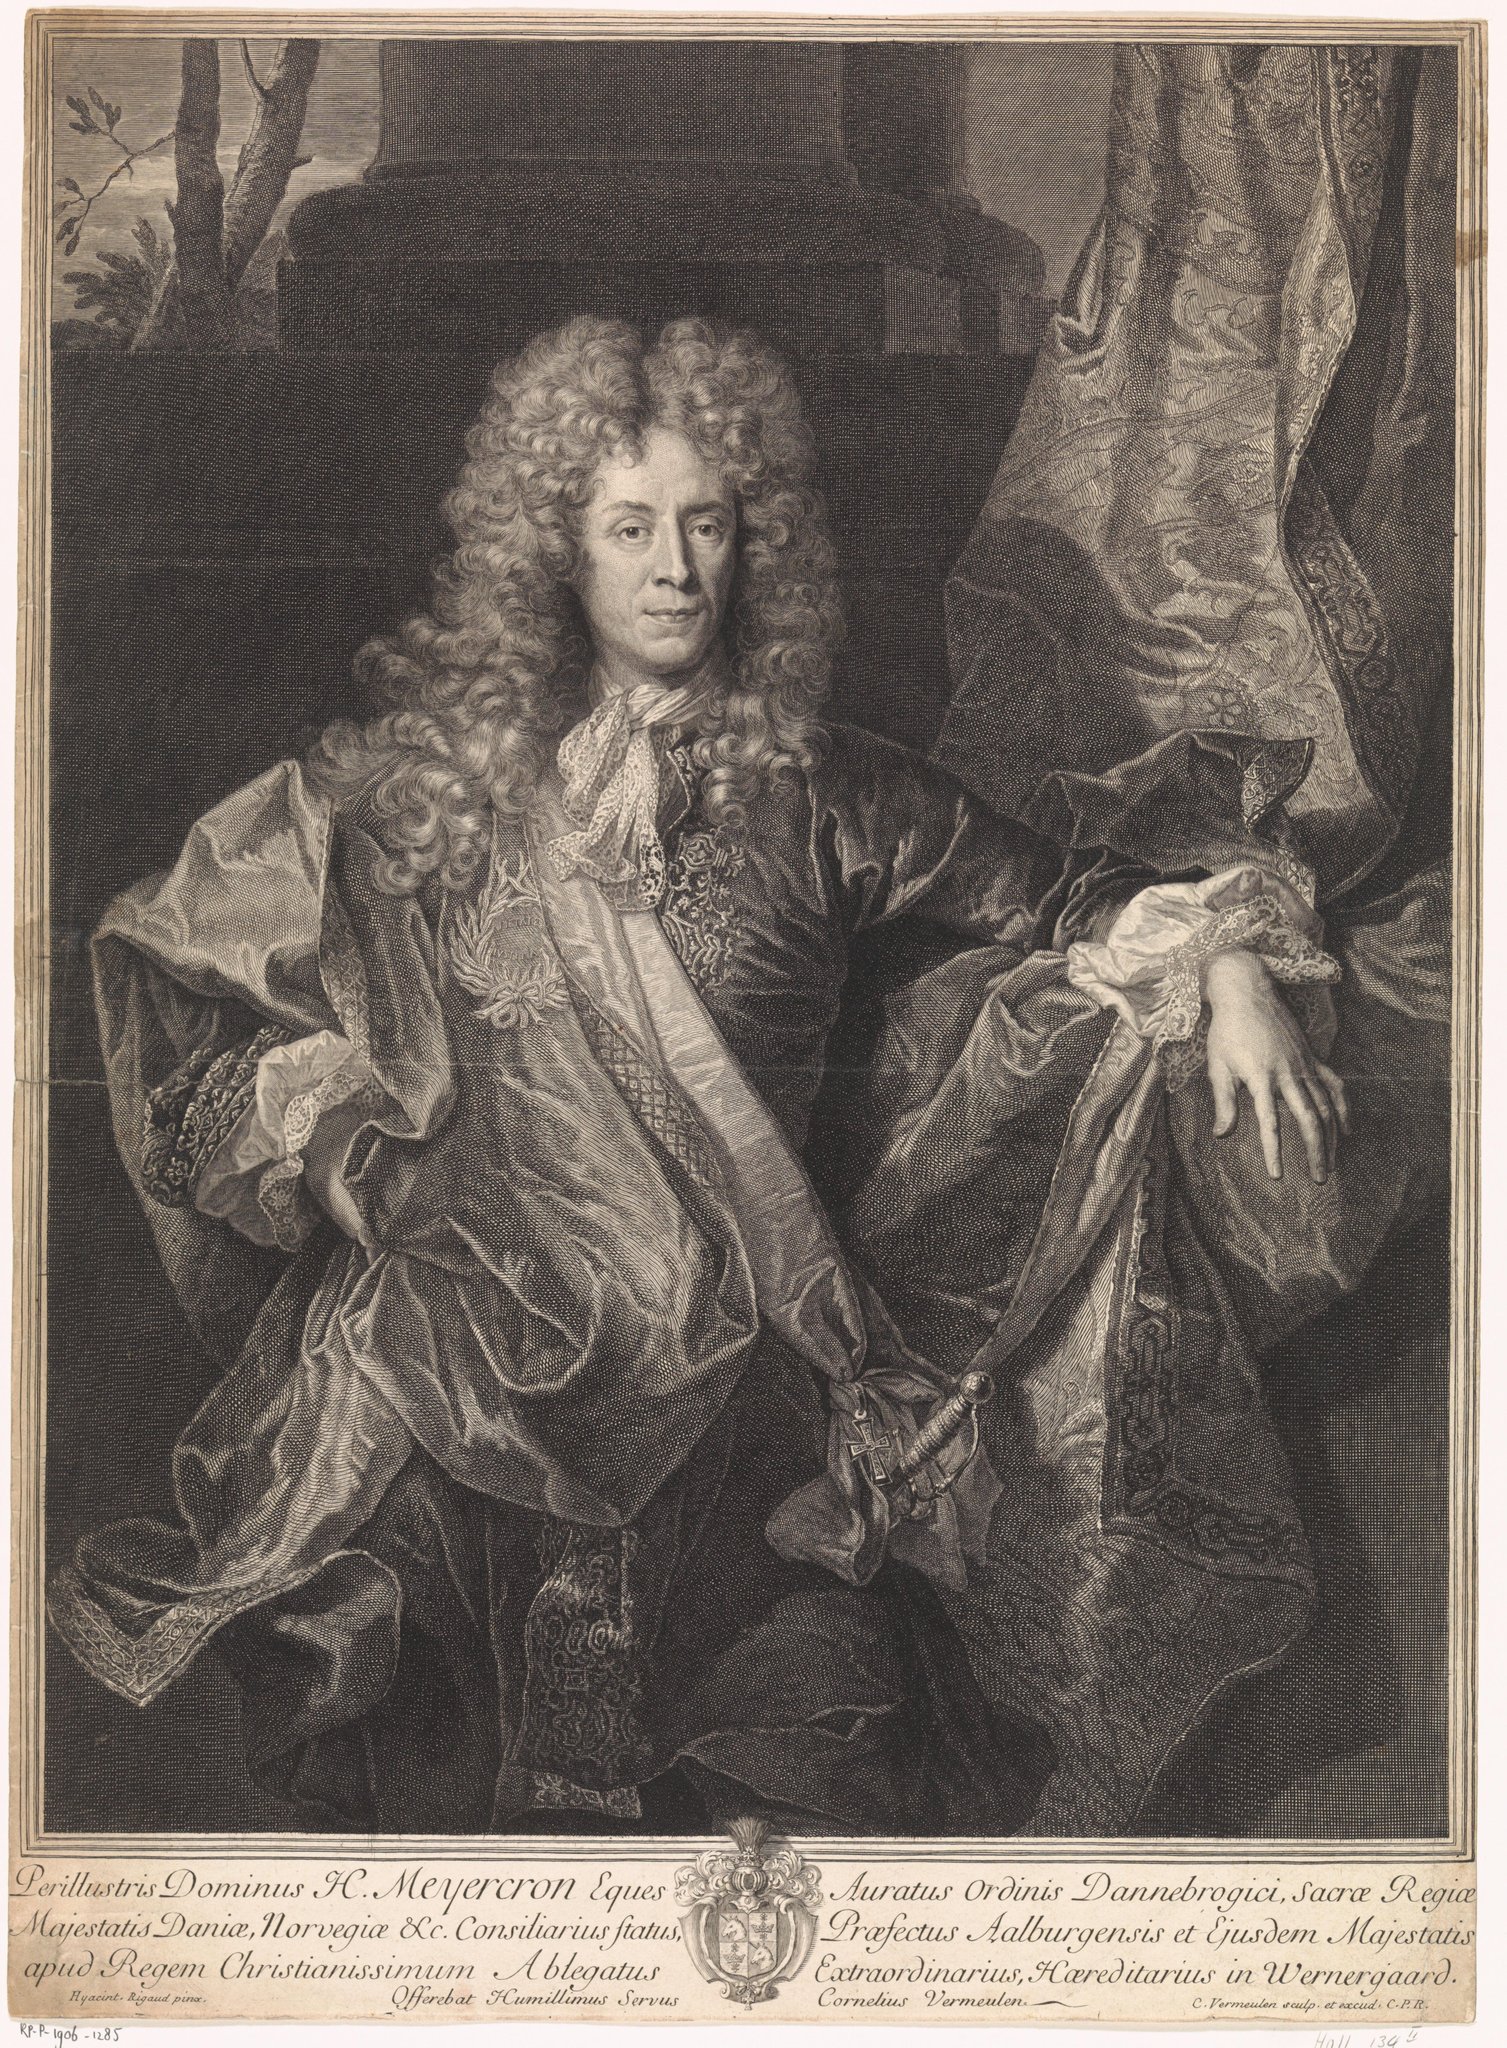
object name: print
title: Portret van Henning Meyer de Meyercron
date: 1691-1707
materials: paper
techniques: engraving, etching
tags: copenhagen (city)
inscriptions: collector's mark: Lugt 2228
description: Portret van de Deense diplomaat Henning Meyer de Meyercron.